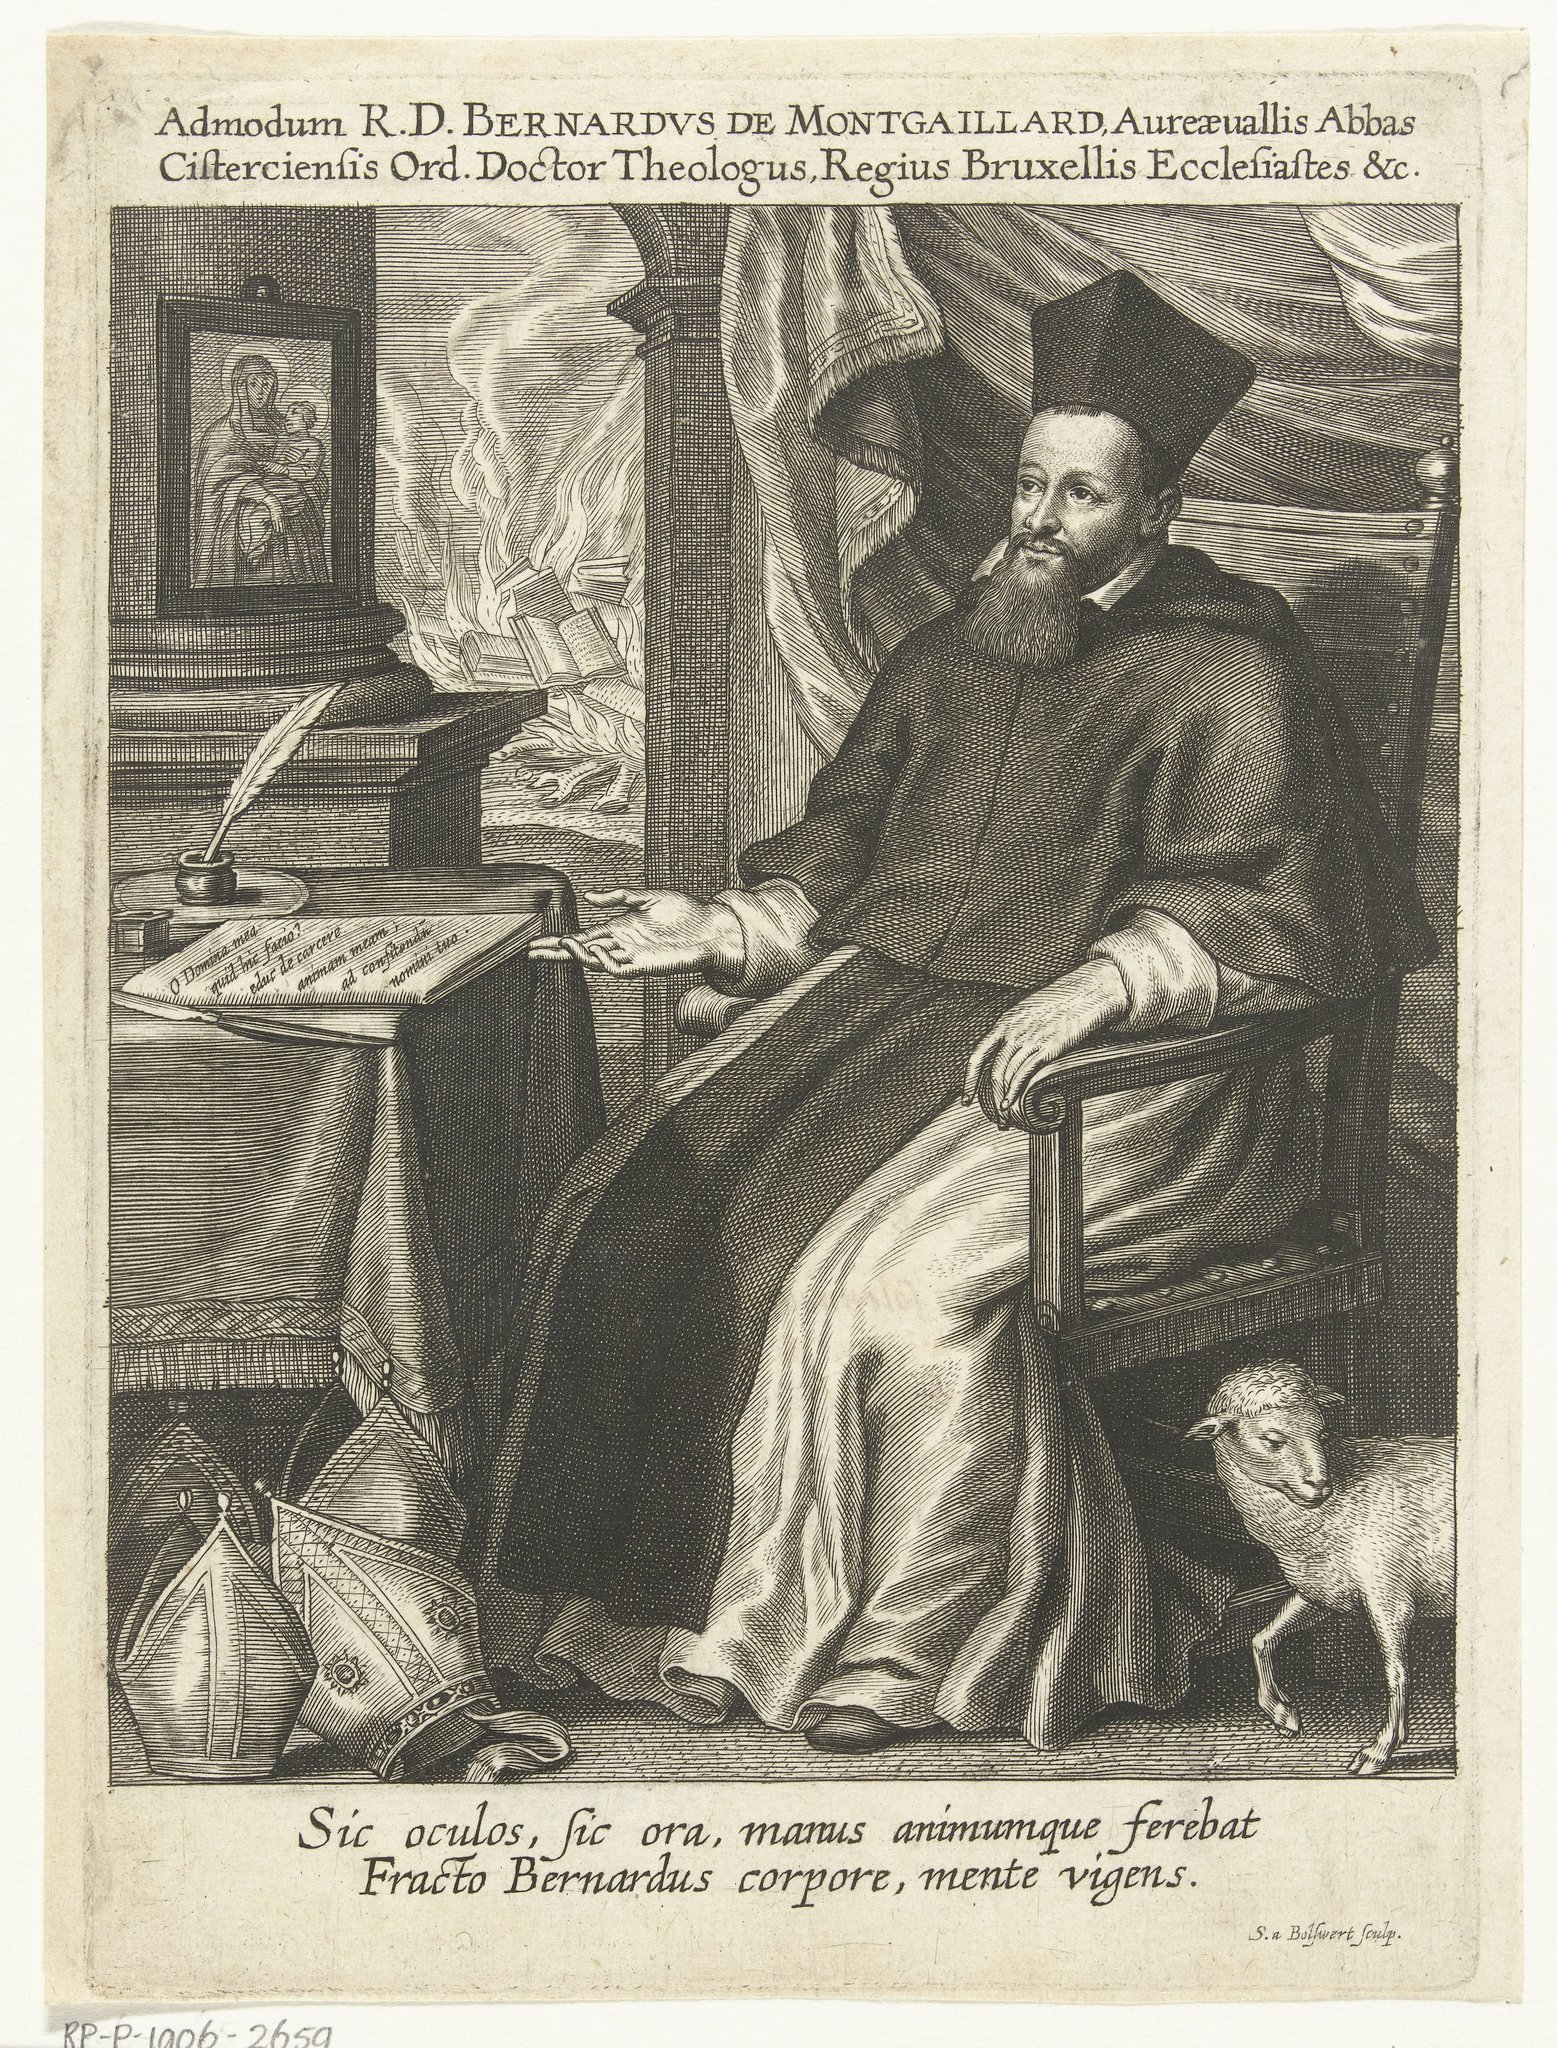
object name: print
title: Portret van priester Bernard de Montgaillard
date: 1596-1659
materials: paper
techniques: engraving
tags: priest, priest (roman catholic)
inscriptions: collector's mark: Lugt 240, inscription: ‘Admodum R.D. Bernardvs ... Regius Bruxellis Ecclesiastes &c.’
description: Portret van priester Bernard de Montgaillard zittend bij een tafel met zijn geschrift. Op de grond staan vier mijters en een lam. Op de achtergrond worden boeken verbrand. Onder de voorstelling staat een vers in Latijn.